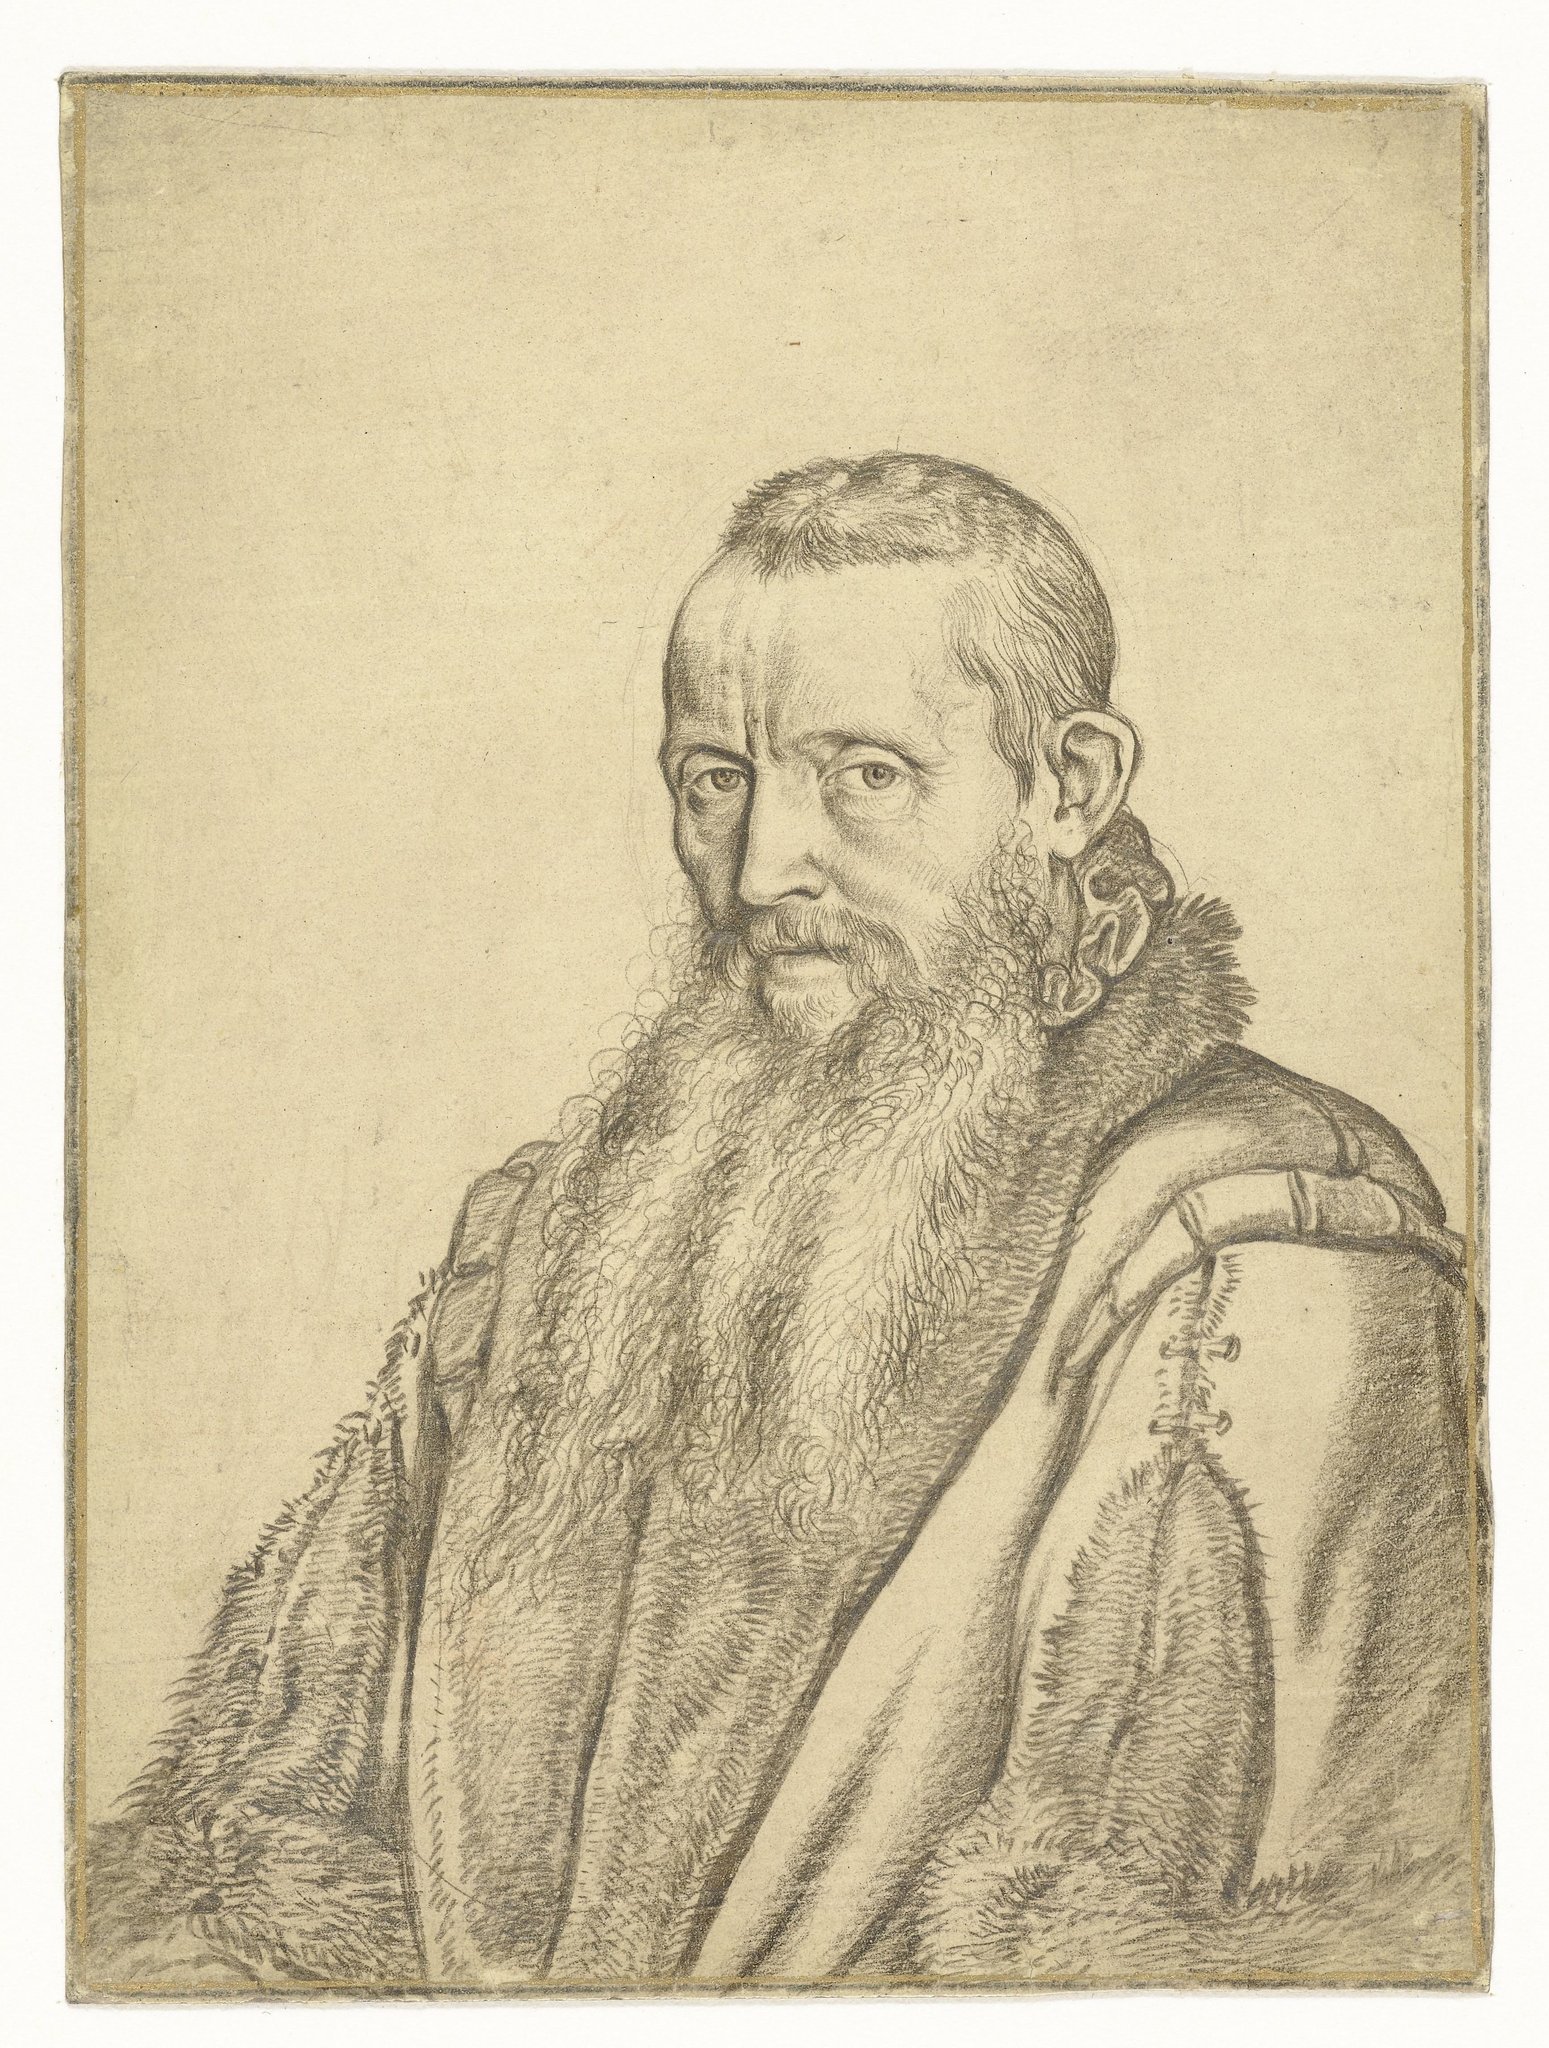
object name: drawing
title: Portret van een theoloog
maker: hendrick goltzius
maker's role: draughtsman, painter, print maker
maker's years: 1558-1617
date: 1585-1590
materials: paper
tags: theologian, scholar, philosopher, coat (+ men's clothes), sleeves (+ men's clothes), beard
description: Kleding: de man heeft een lange, gespleten baard* en een korte snor. Hij draagt een tabbaard* met bontvoering en platte schouderkleppen*, waaronder een klein stukje van zijn lubbenkraag* te zien is.